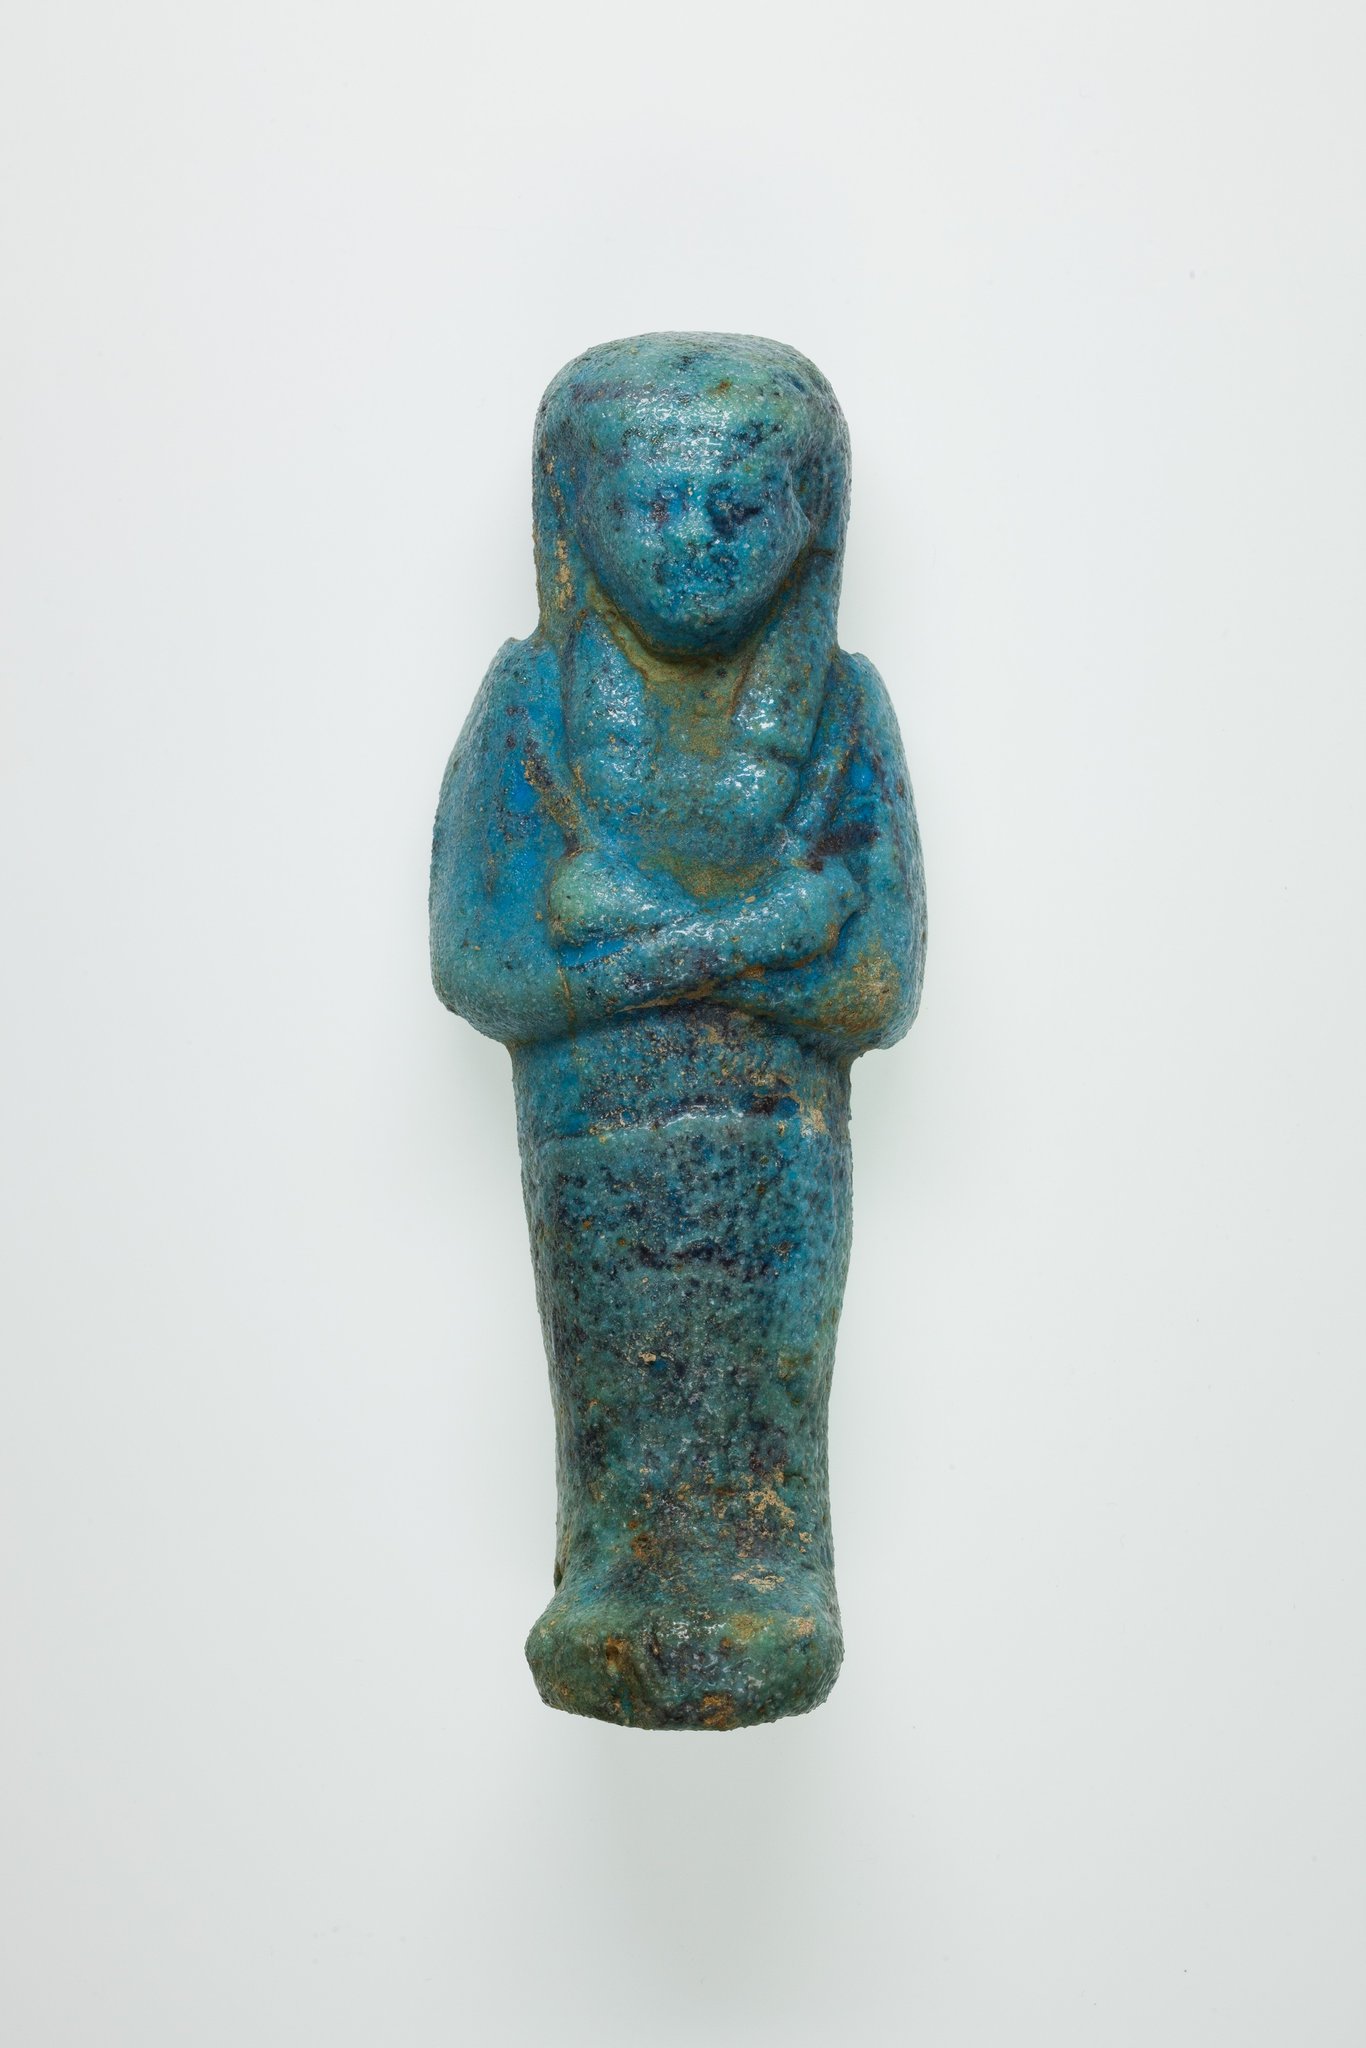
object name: shabti, henettawy c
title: Worker Shabti of Henettawy (C), Daughter of Isetemkheb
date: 990-970 BCE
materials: faience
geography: egypt